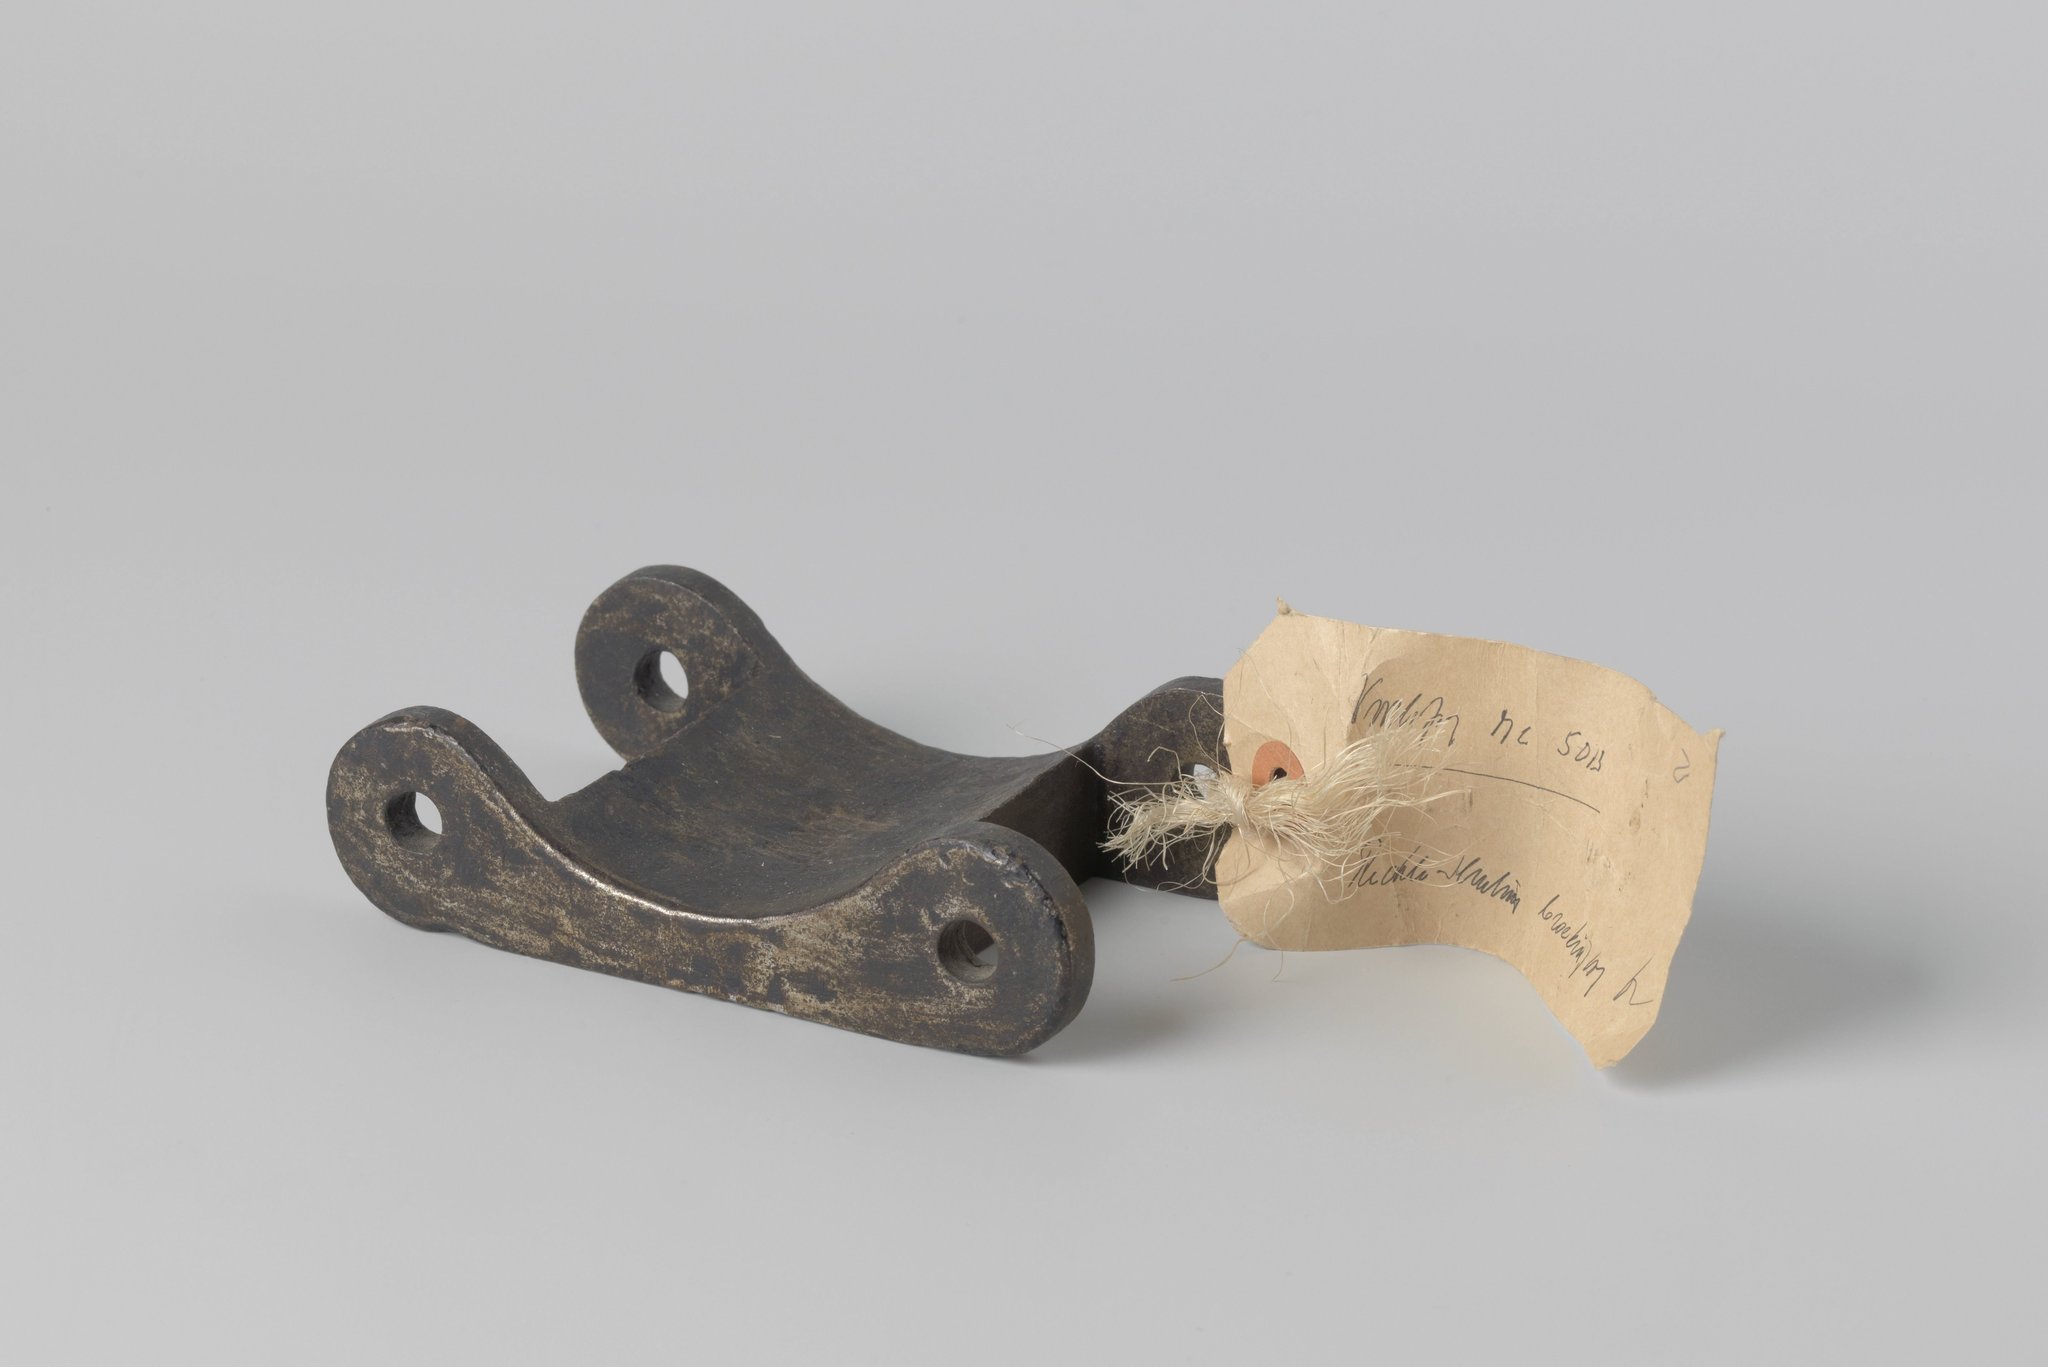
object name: fastening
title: Broeking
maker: Anonymous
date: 1850-1900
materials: iron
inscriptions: inscription: ‘100V’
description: IJzeren, gladde broeking voorzien van vier ogen waarmee deze om een mast of pomp kan worden bevestigd om het binnendringen van lekwater te voorkomen.